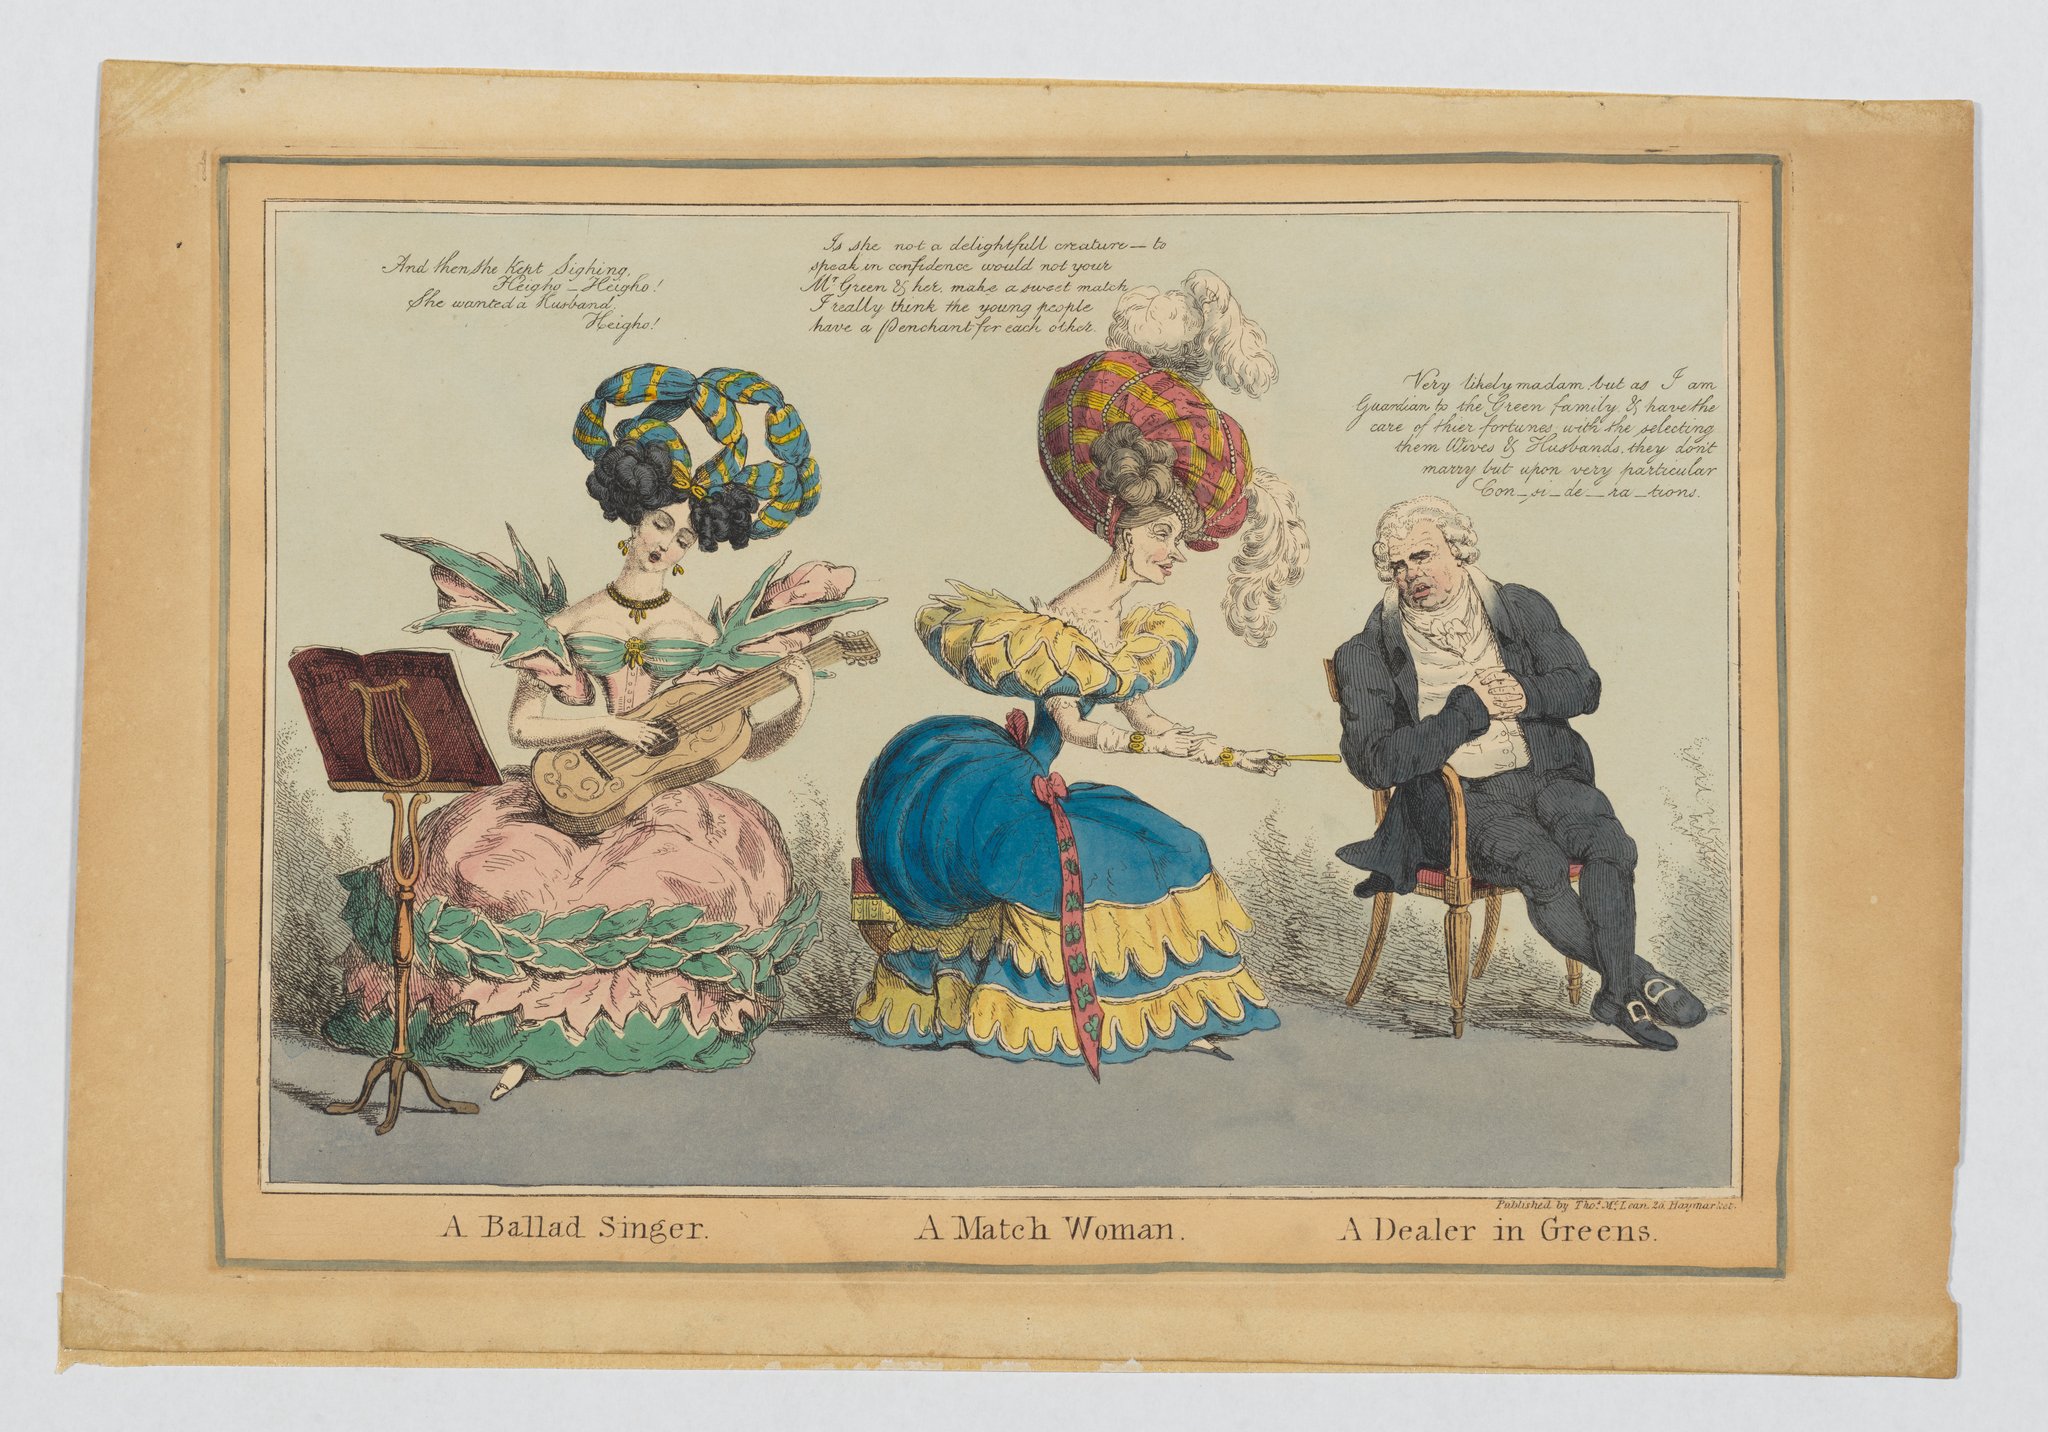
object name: print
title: Ballad Singer, A Match Woman, A Dealer in Greens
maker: william heath ('paul pry')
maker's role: artist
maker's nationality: british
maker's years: 1794-1840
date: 1825-1830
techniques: etching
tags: satire,men,women,guitars